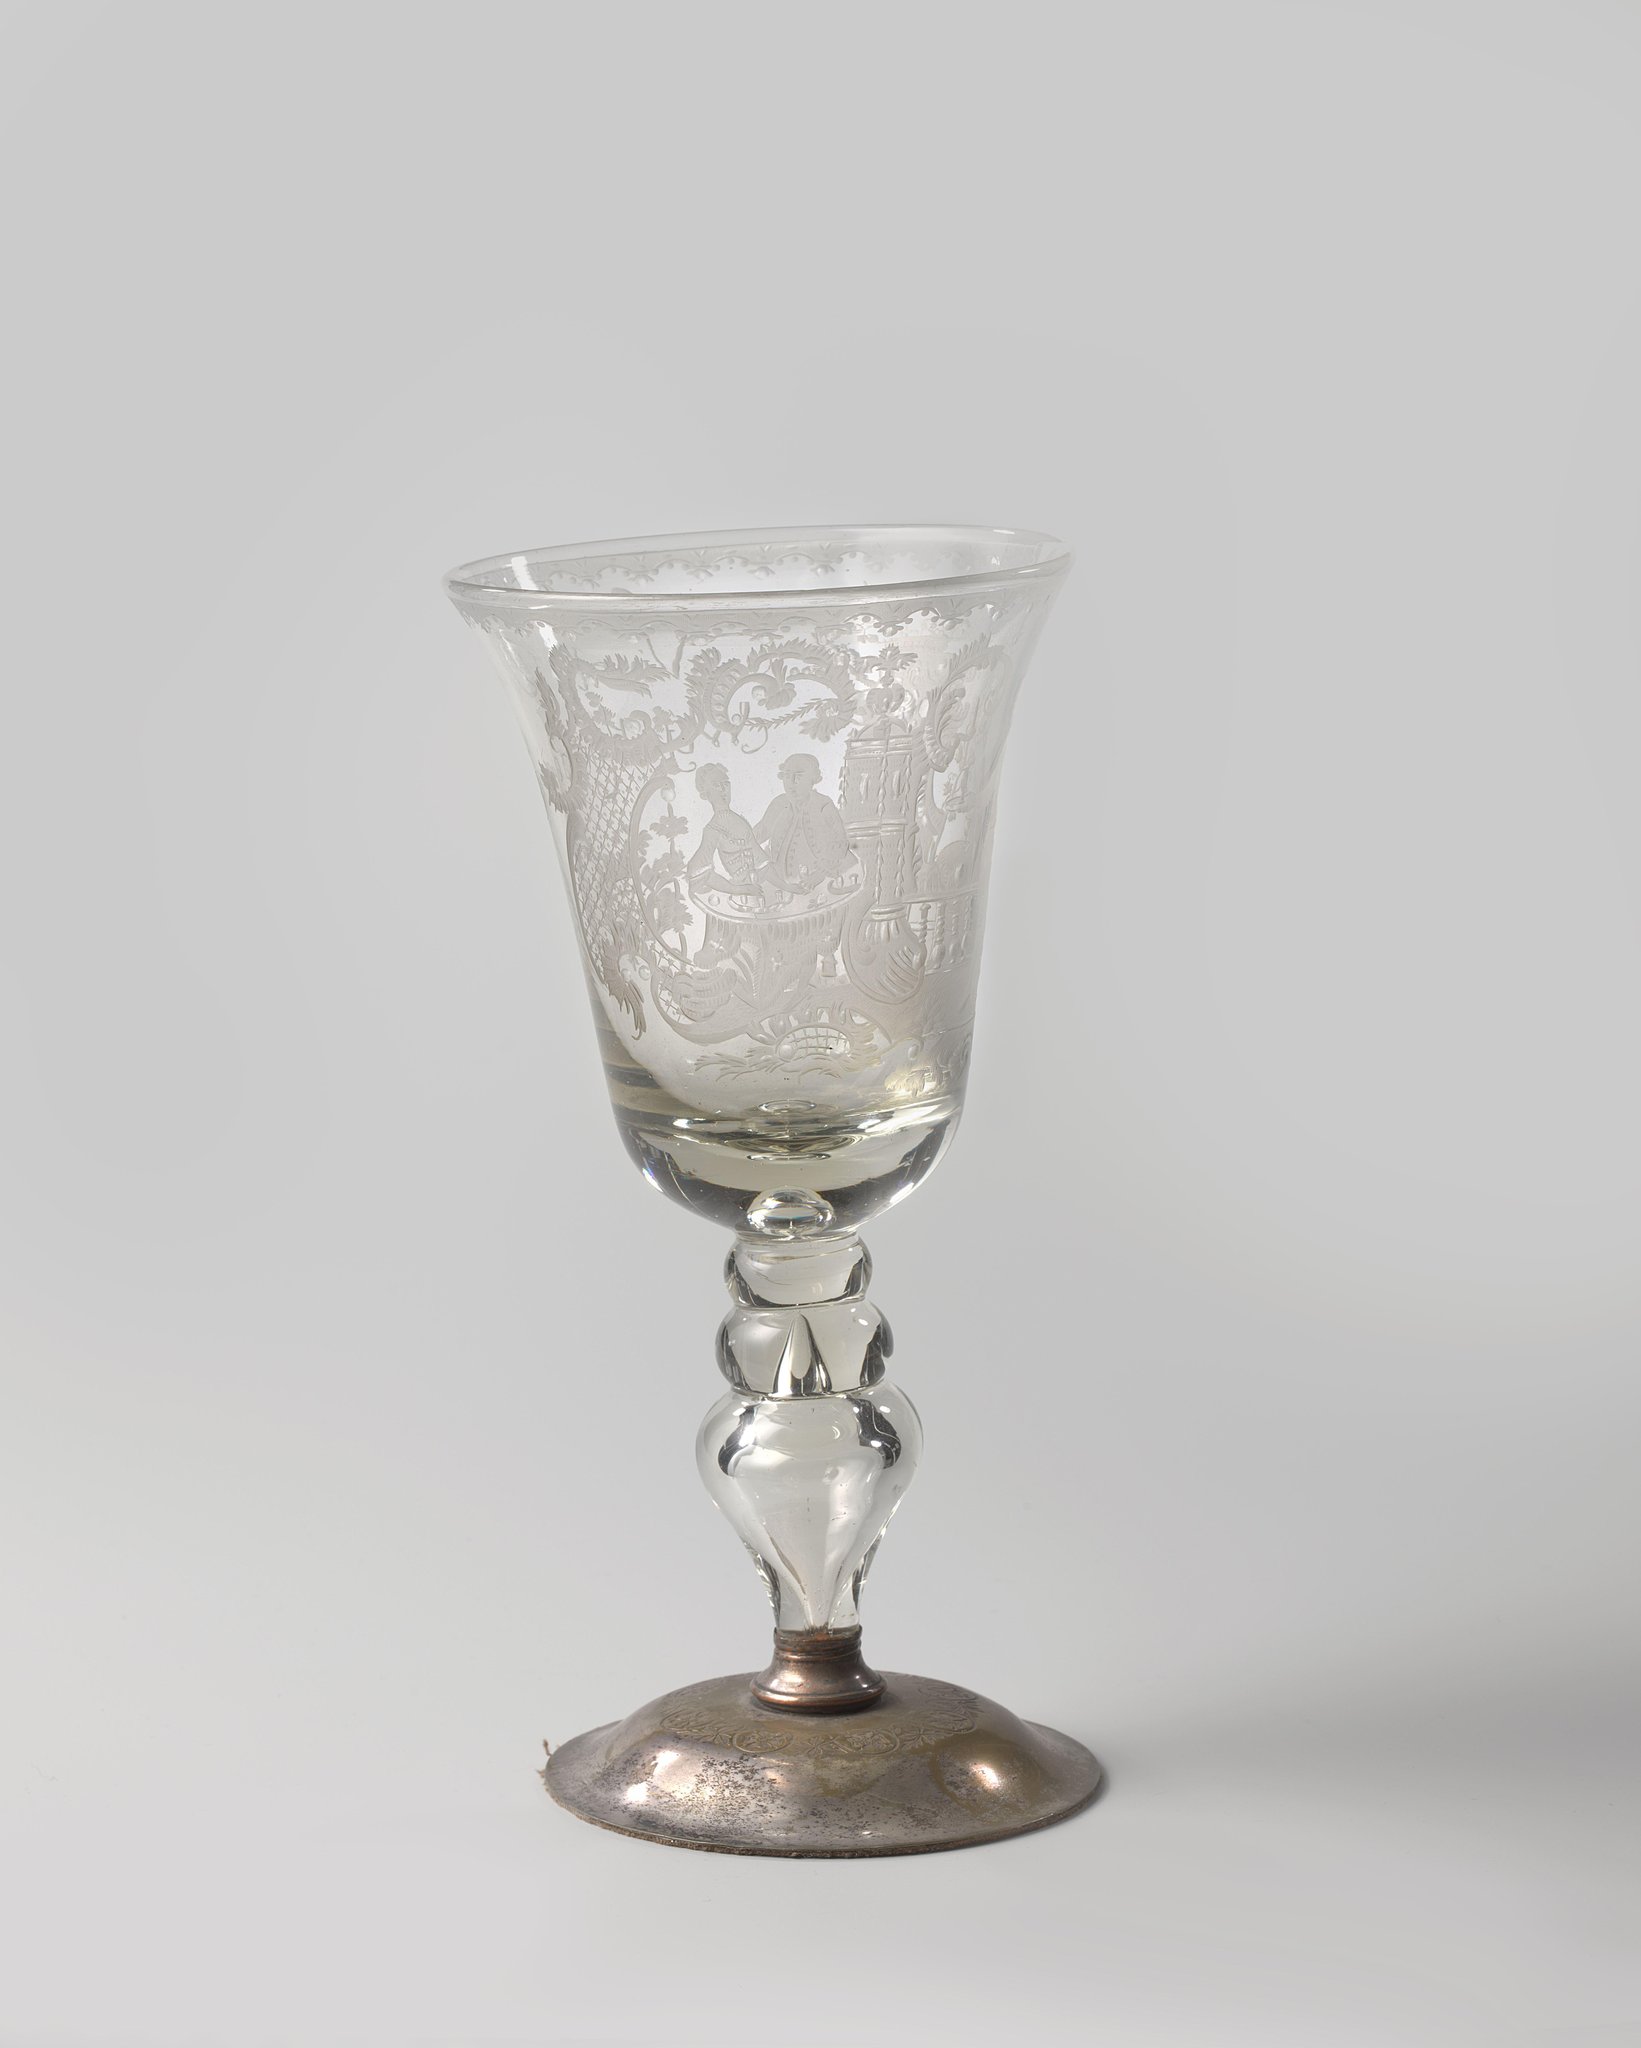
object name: goblet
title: Bokaal met een gezelschap op een terras en het opschrift: Vivat, De WijnKooperij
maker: Anonymous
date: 1740-1750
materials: copper, glass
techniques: glassblowing, silvering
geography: germany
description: Gewelfde voet van verzilverd koper. Balusterstam met drie knopen en een langgerekte luchtbel. Op de kolokvormige kelk een gegraveerde voorstelling van een heer en een dame met een bediende op een terras en het opschrift: Vivat, De/ WijnKooperij.